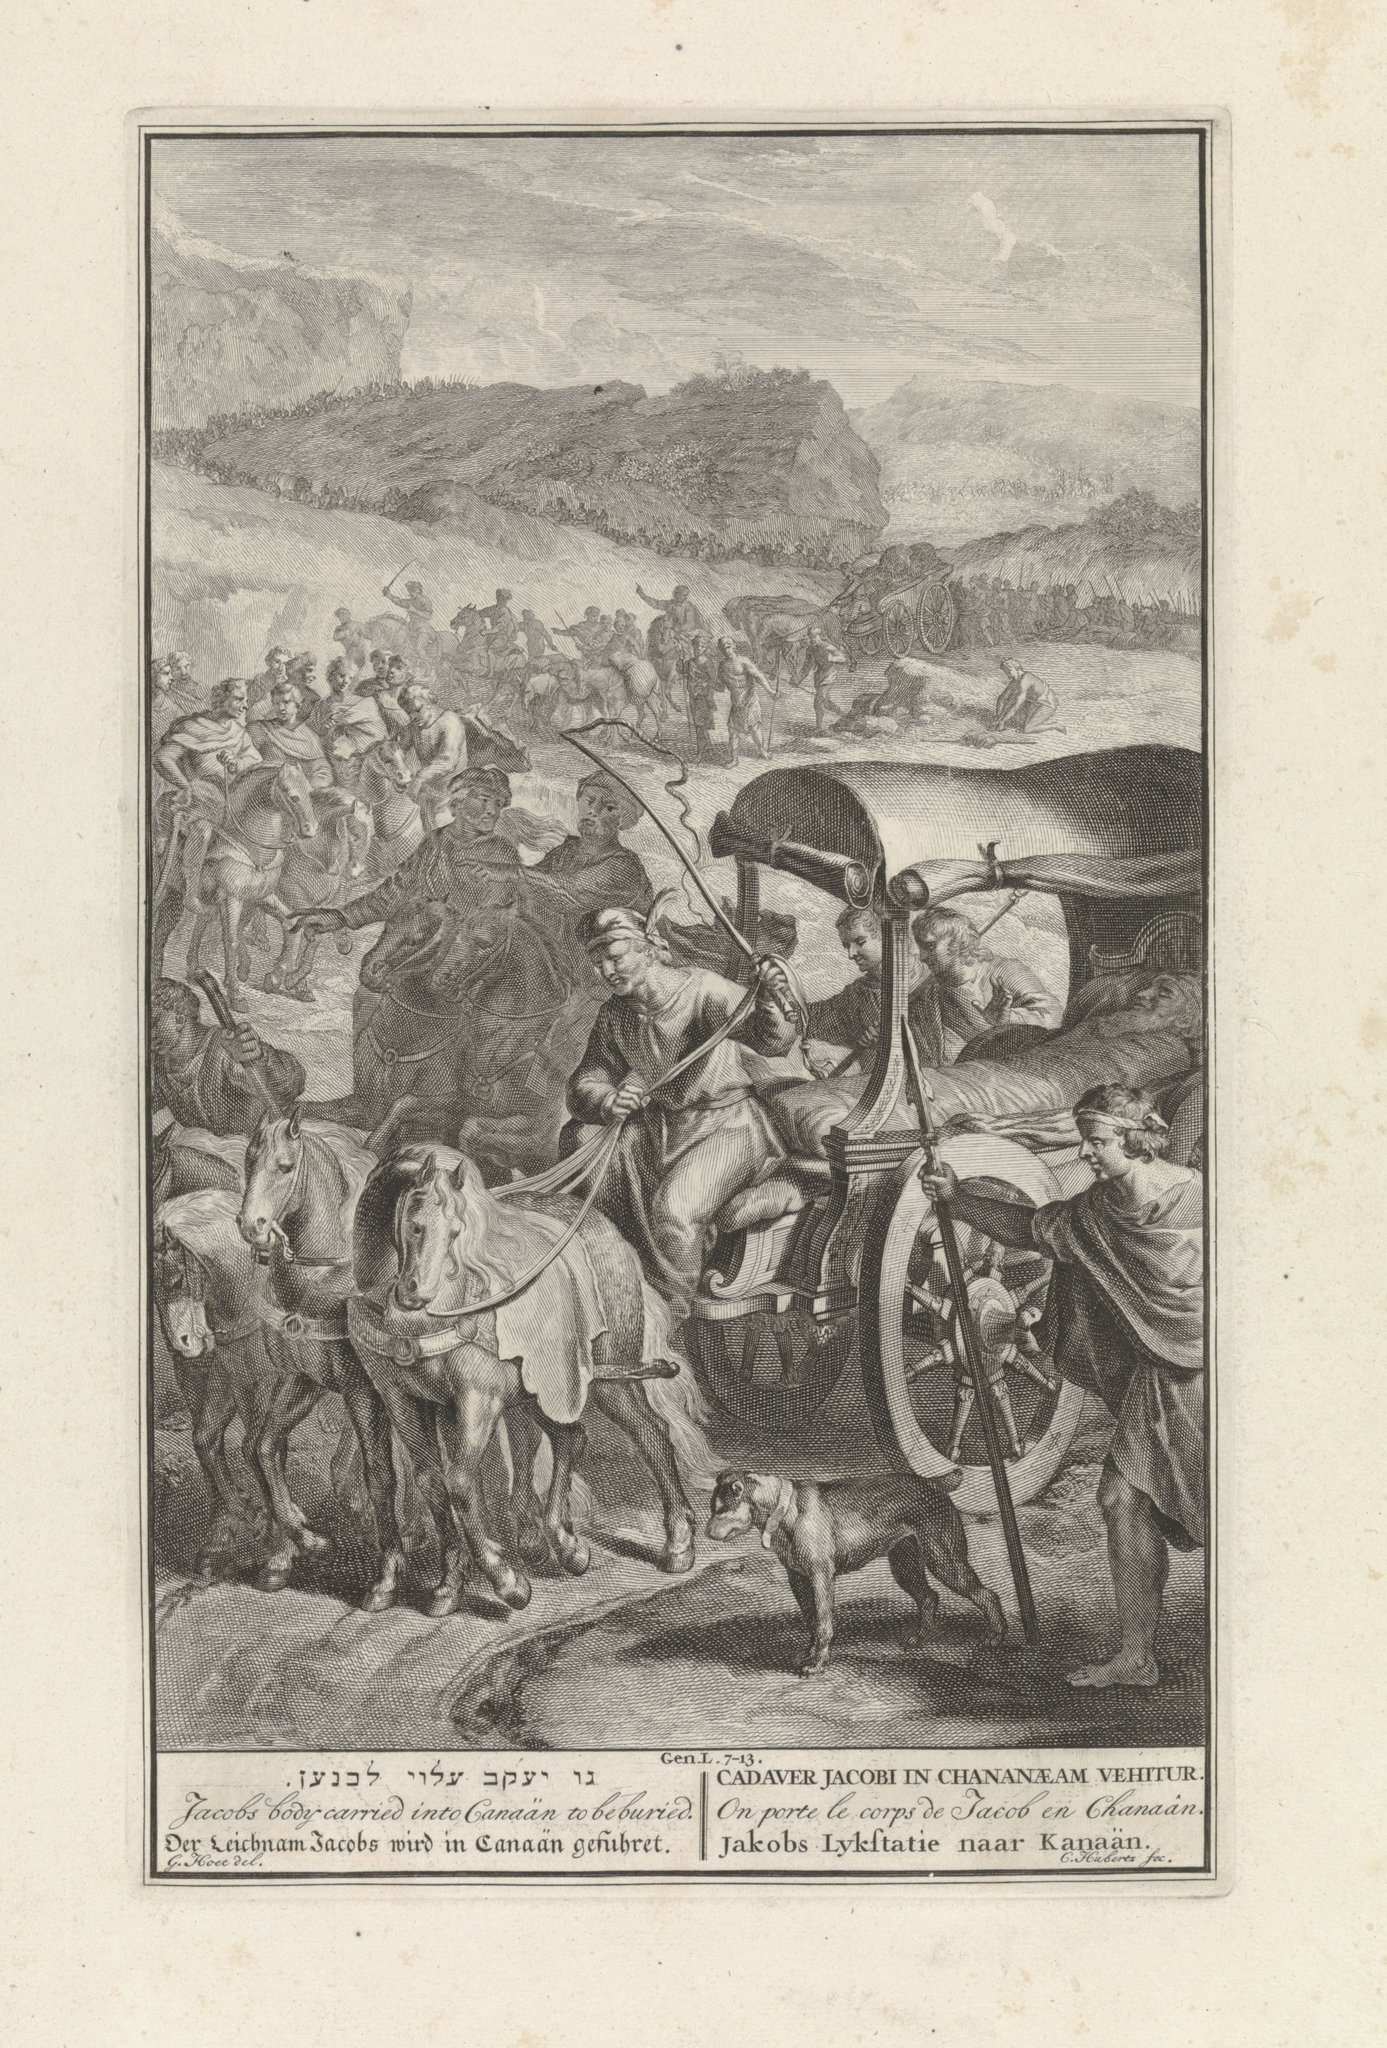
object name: book illustration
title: Jakobs lichaam wordt naar Kanäan gebracht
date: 1720-1728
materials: paper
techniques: engraving, etching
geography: amsterdam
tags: joseph has his father's corpse brought to canaan with great pomp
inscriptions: collector's mark: Lugt 2228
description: Prent gemaakt voor: Figures de la Bible. Amsterdam, Bernard Picart, 1720. Prent ook gebruikt in: Taferelen der voornaamste geschiedenissen van het Oude en Nieuwe Testament (...) door de vermaarde kunstenaars Hoet, Houbraken, en Picart getekent (...) en met beschrijvingen uitgebreid. Den Haag: Pieter de Hondt, 1728.